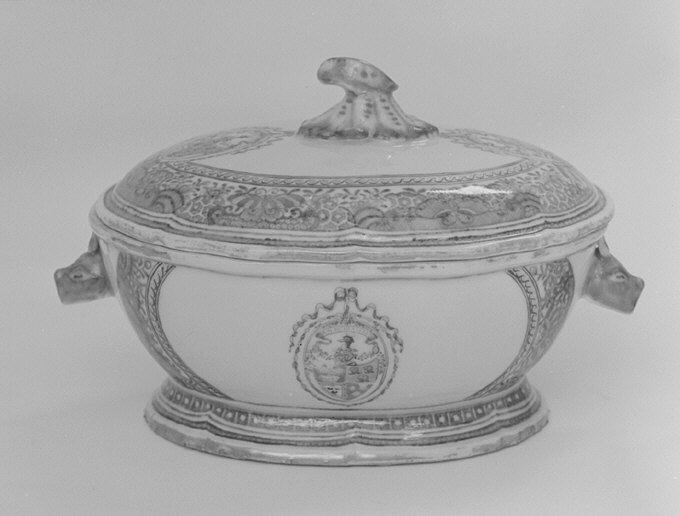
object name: sauceboat with cover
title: Sauceboat with cover (part of a service)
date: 1770-1785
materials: hard paste porcelain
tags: flowers